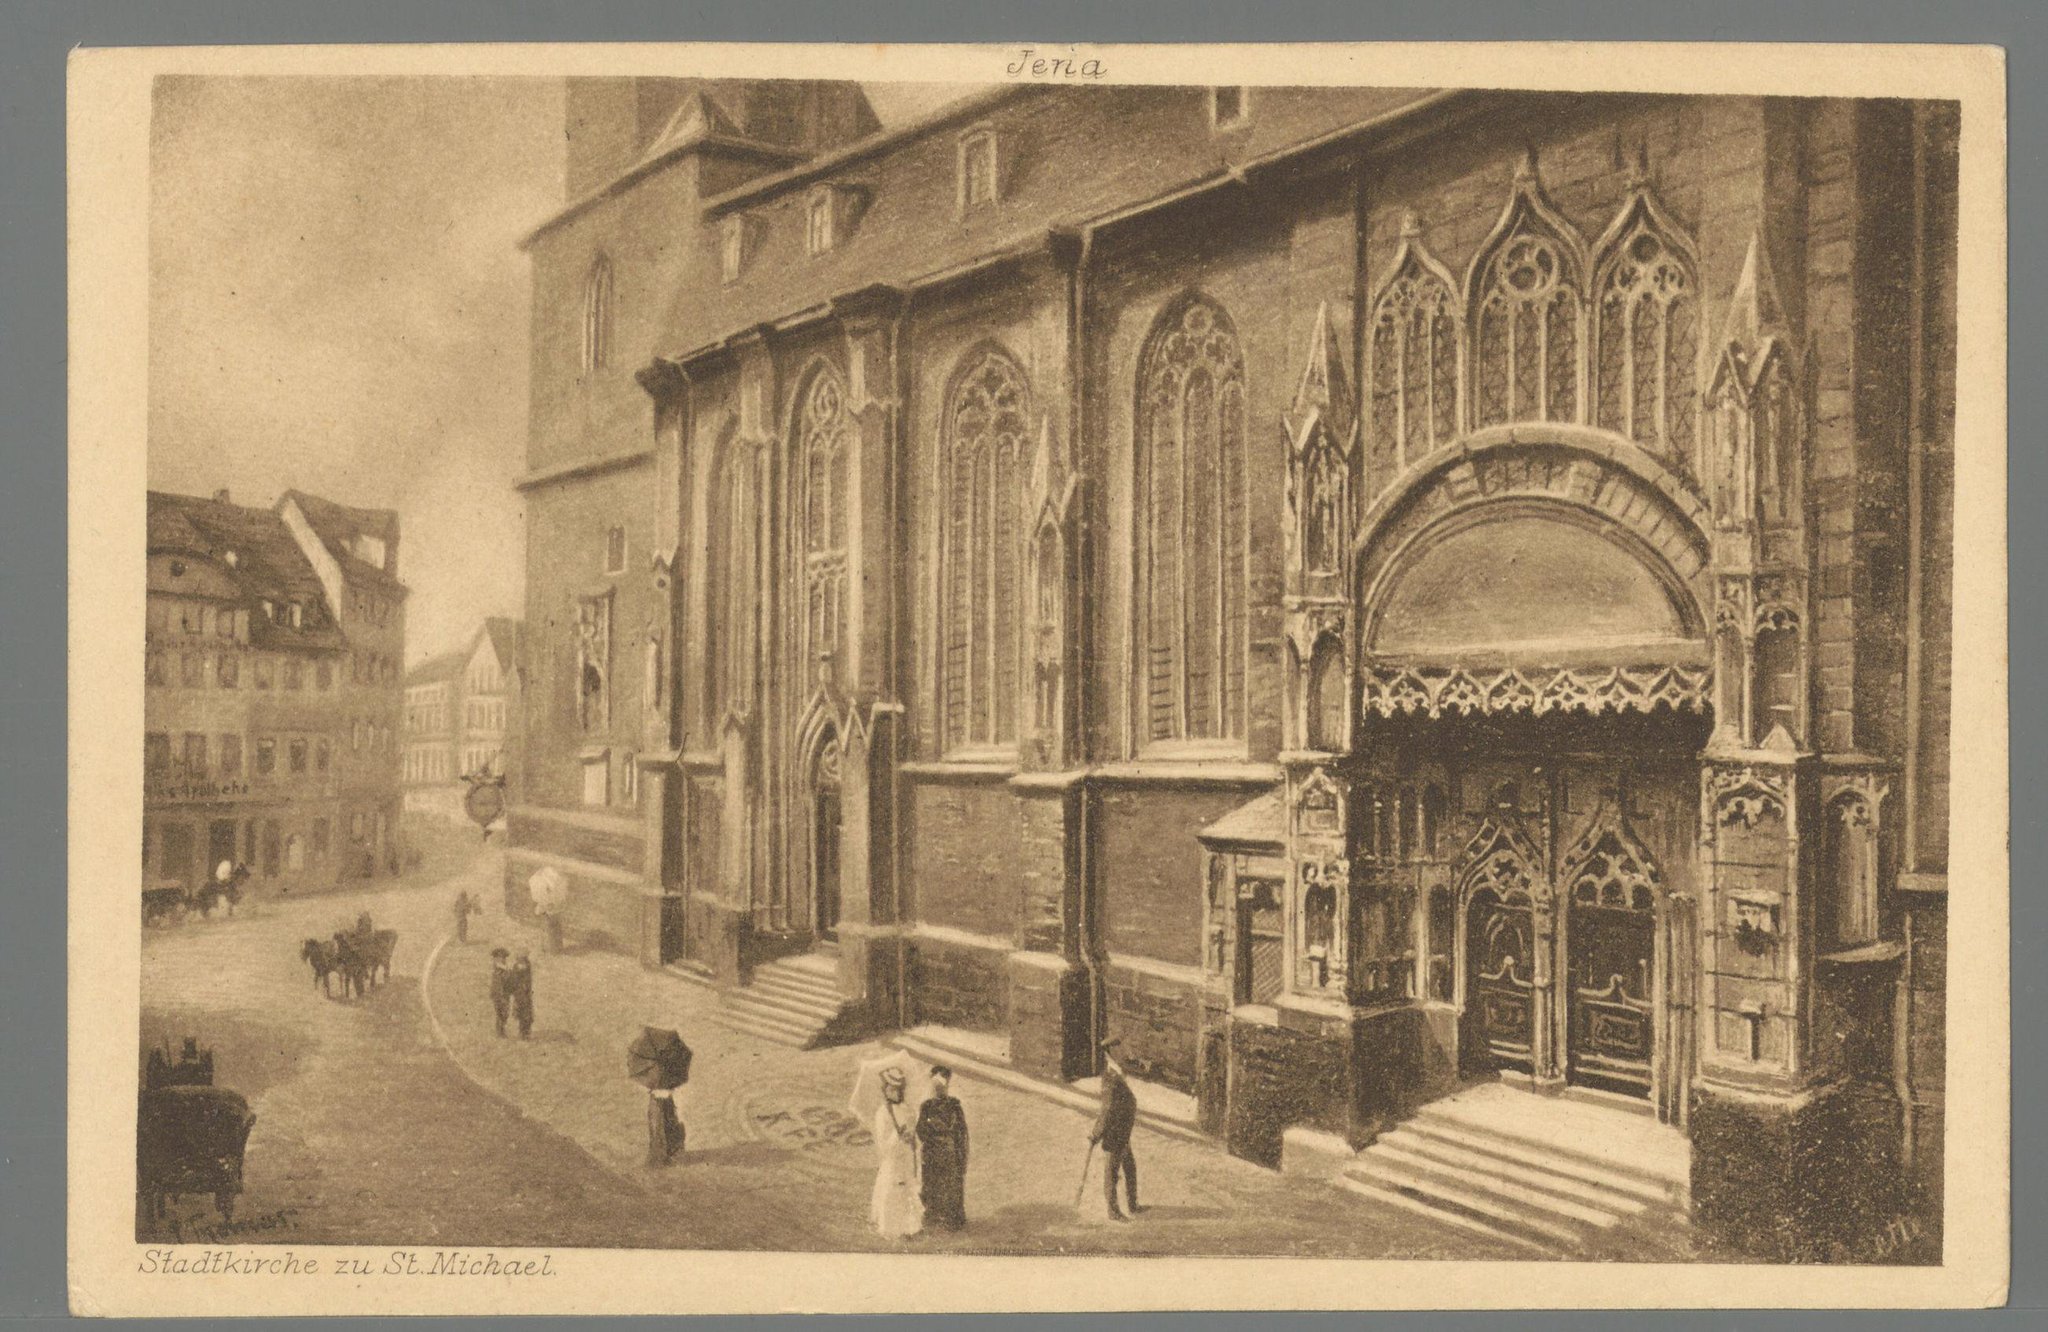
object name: reproduction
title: Jena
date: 1908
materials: cardboard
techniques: rotogravure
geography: berlin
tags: church (exterior)